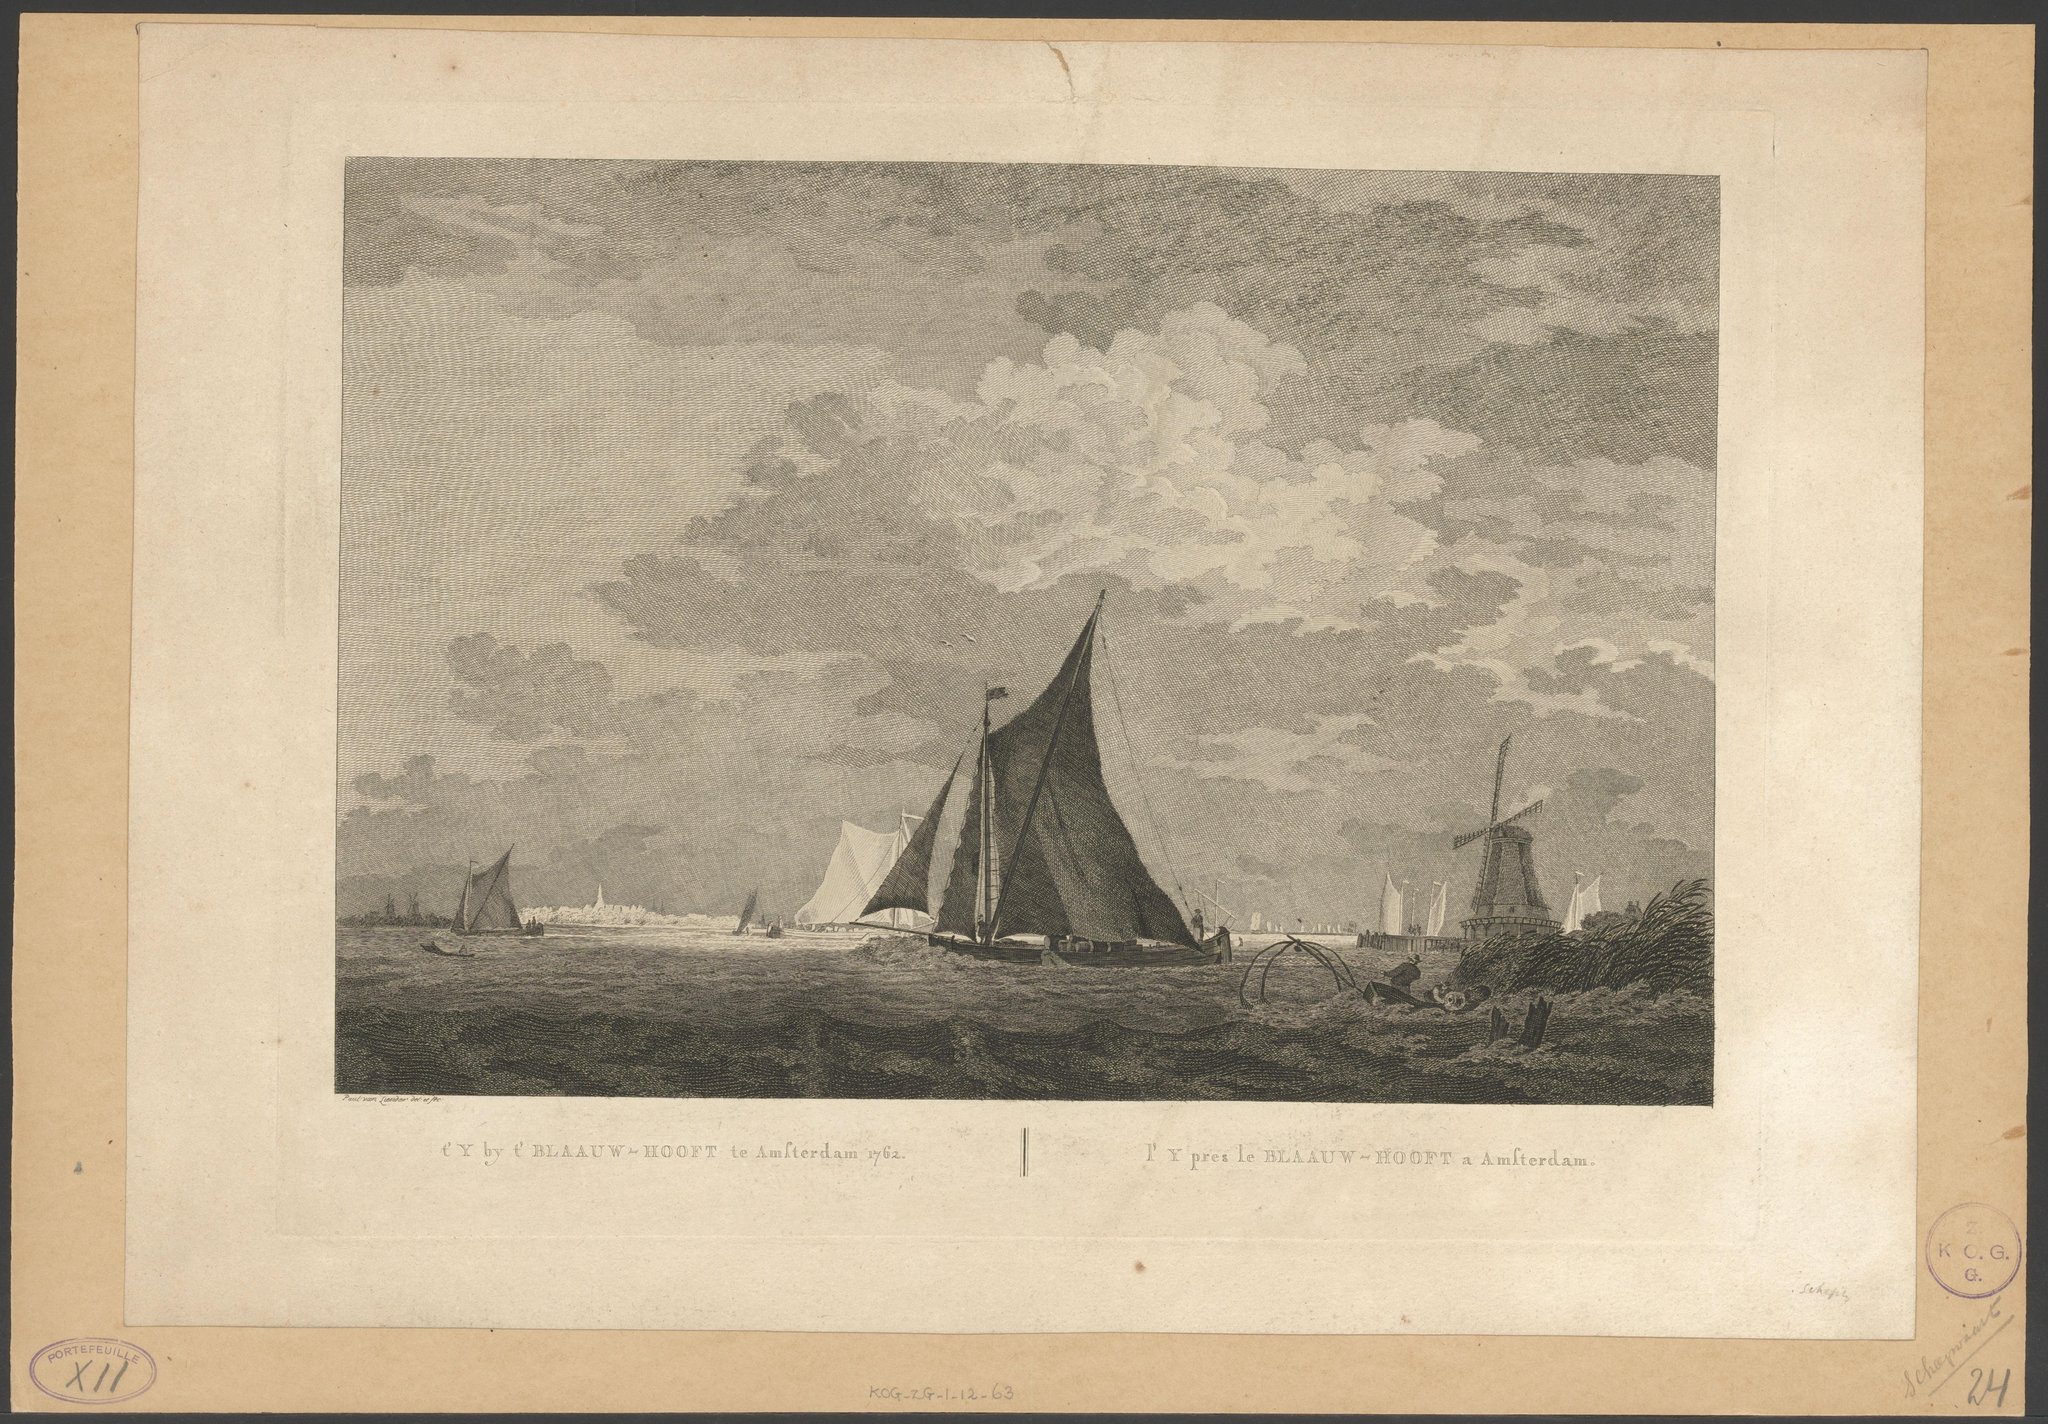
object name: print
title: Schepen op het IJ bij het Blauwhoofd te Amsterdam, 1762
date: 1762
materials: paper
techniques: engraving, etching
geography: amsterdam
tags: sailing-ship, sailing-boat, landscapes with waters, waterscapes, seascapes (in the temperate zone), rowing-boat, canoe, etc., windmill, amsterdam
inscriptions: collector's mark: Lugt 1641, stamp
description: Latere staten van deze prent zijn ook gebruikt in de zogenaamde Atlas van Fouquet.* Pierre Fouquet gaf vanaf 1760 stadsgezichten van Amsterdam - naar tekeningen van verschillende kunstenaars, gemaakt door verschillende prentmakers - uit. Deze prenten werden aanvankelijk los of in series verkocht. Zoals toen gebruikelijk kon de koper de prenten zelf laten inbinden. Hiertoe gaf Fouquet tussen 1778 en 1783 een titelblad, plattegrond en inhoudsopgave van de tot dusver 100 uitgegeven prenten uit (1). Gezien de inhoud afhankelijk was van wat de koper had verzameld verschilt de inhoud van de verschillende bewaarde Fouquetatlassen onder deze titel sterk. Ook zijn er exemplaren bekend waar tevens andere prenten aan zijn toegevoegd. Omdat er behoefte bleek aan uitleg bij de platen werd in 1783 een nieuwe versie van de atlas uitgegeven, aangevuld met tekst en twee prenten. De aangegeven volgorde veranderde maar de platen van de al eerder uitgegeven prenten bleven ongewijzigd. Deze uitgave werd in opdracht van Fouquet gedrukt bij Daniël Jean Changuion en Petrus den Hengst (2). Een tiental platen werd bijgewerkt en verscheen, met nieuw impressum, in het vervolg van Wagenaars geschiedenis van Amsterdam, uitgeven door Petrus Conradi en Folkert van der Plaats (3). Een aantal jaar na het overlijden van Fouquet kwam Evert Maaskamp met een nieuwe uitgave van de atlas, met verbeterde tekst en toevoeging van twee prenten. Op alle platen verwijderde hij het oude en liet hij zijn eigen impressum zetten (4). * Onder de Atlas van Fouquet of Fouquetatlas verstaan we de hieronder vermelde publicaties (1), (2) en (4). (1). Afbeeldingen van de wyd-vermaarde koopstad Amsterdam benevens des zelvs voornaamste gebouwen en gezigten alle naar het leeven getekend / Receuil des edifices les plus considerables et des plus belles vues, de la fameuse ville d'Amsterdam, dessinées d'après nature. Amsterdam: Pierre Fouquet, 1778-1783. (2). Nieuwe atlas, van de voornaamste gebouwen en gezigten der stad Amsterdam, met derzelver beknopte beschryvingen. 2 dln. Amsterdam: Daniël Jean Changuion en Petrus den Hengst [in opdracht van Pierre Fouquet], 1783. (3). Stijl, Simon. Amsterdam, in zyne geschiedenissen, voorregten, koophandel, gebouwen, kerkenstaat, schoolen, schutterye, gilden en regeeringe, beschreeven. Om te dienen ten vervolge op het werk van Jan Wagenaar (…). 10 dln. Amsterdam en Harlingen: Petrus Conradi en Folkert van der Plaats, 1788-1801. (4). Nieuwe atlas, van de voornaamste gebouwen en gezigten der stad Amsterdam. Met derzelver beknopte beschryvingen. Amsterdam: Evert Maaskamp, 1805. * Het aantal vermelde staten is gebaseerd op het aantal gevonden staten. Mogelijk zijn er meer staten van deze prent. Voor tweede bekende staat zie RP-P-1911-3088. Voor vierde bekende staat zie RP-P-AO-20-80A.